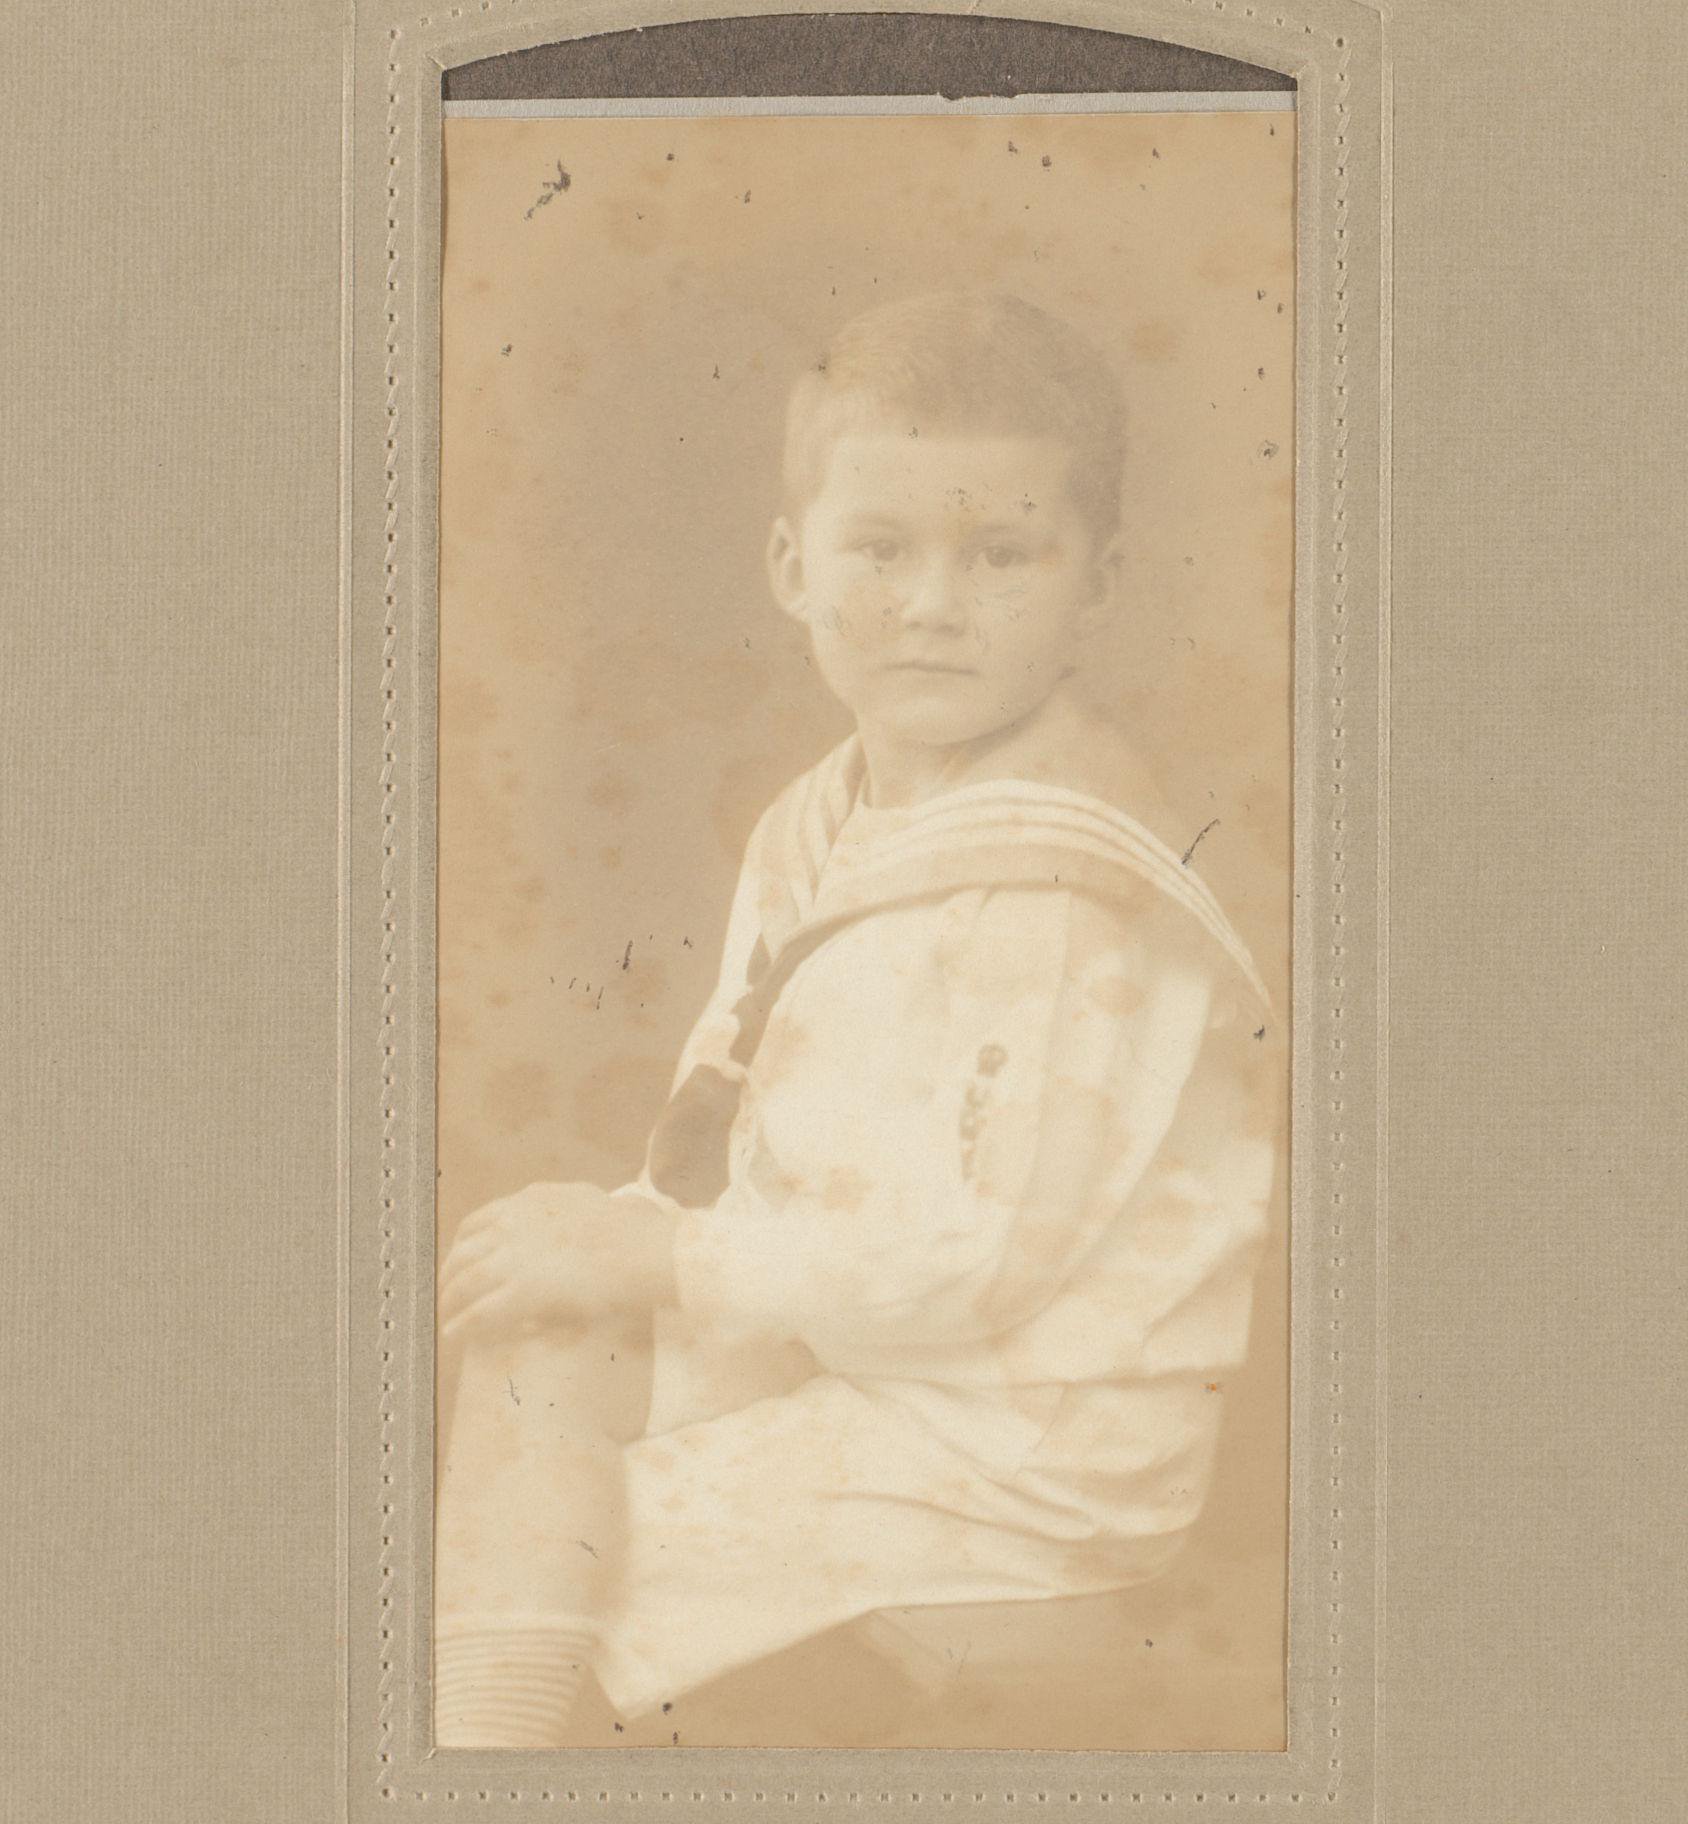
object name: photograph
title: Studioportret van een jongetje in matrozenpakje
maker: geldolph adriaan kessler (dolph)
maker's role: fotograaf, industrieel, voetballer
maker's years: 1884-1945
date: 1890-1920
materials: paper, photographic support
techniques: gelatin silver print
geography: the hague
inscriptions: signature: ‘Delboy & Baer’